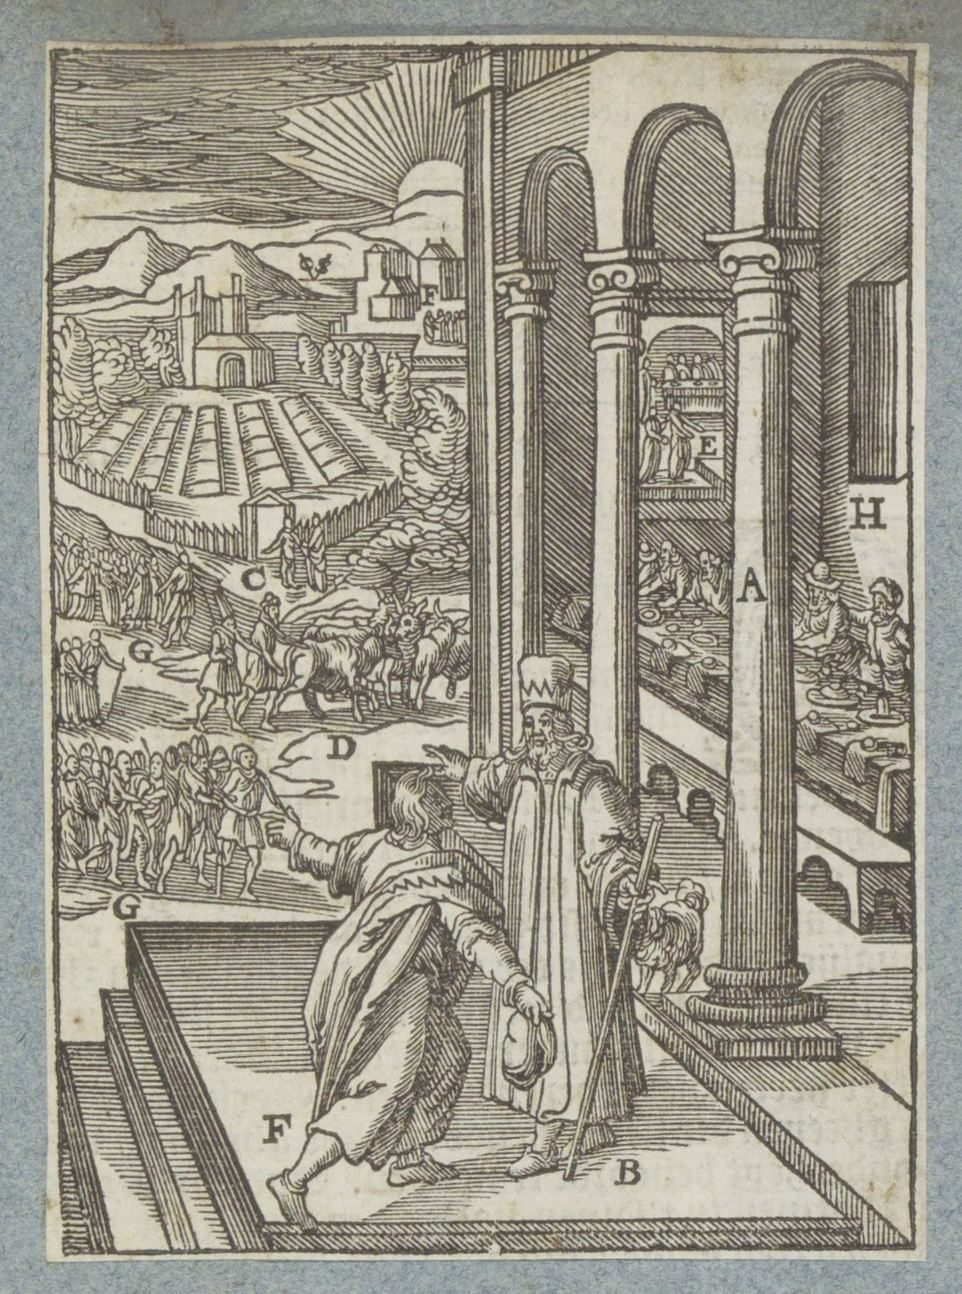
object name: book illustration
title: Gelijkenis van het koninklijke bruiloftsfeest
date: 1629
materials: paper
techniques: letterpress printing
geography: amsterdam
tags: the great supper; the royal wedding-feast ~ parable of christ (matthew 22:1-14; luke 14:16-24)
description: Een koning geeft zijn dienaar de opdracht om gasten uit te nodigen voor een groot feestmaal. Alle gasten weigeren te komen, omdat ze andere zaken te doen hebben: de ene had een hofstede gekocht, de ander had vijf span ossen gekocht en ging ze laten keuren, de derde was net getrouwd en kon daarom niet komen. Daarop geeft de koning de opdracht om iedereen op straat uit te nodigen: de armen, zwakken, blinden en kreupelen. Bij verschillende elementen uit de voorstelling staan letters. De prent maakt deel uit van een album.